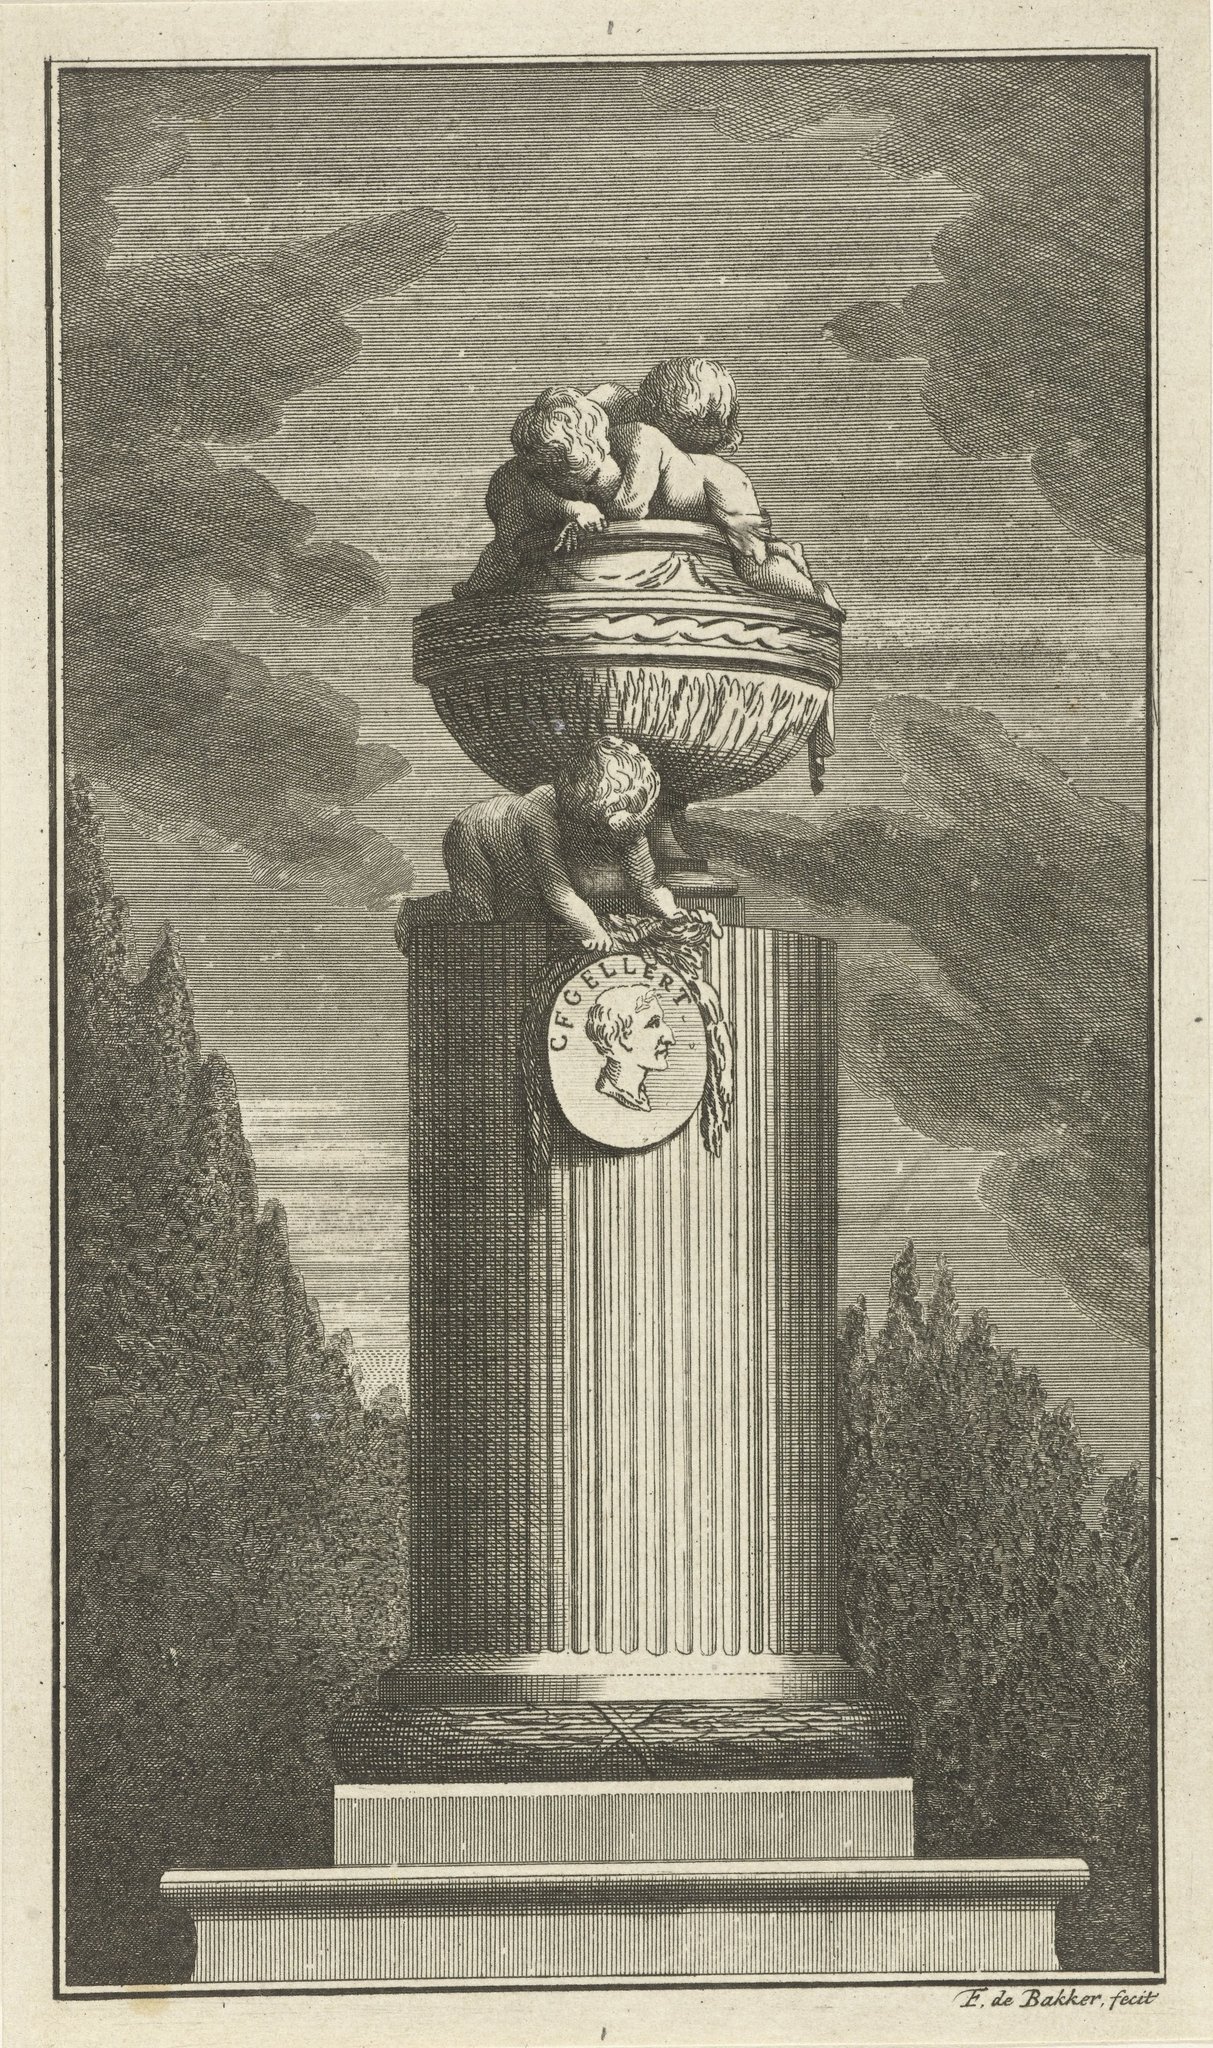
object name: print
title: Monument voor Christian Furchtegott Gellert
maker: frans de bakker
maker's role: print maker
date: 1736-1767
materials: paper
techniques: engraving, etching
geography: amsterdam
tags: grave, tomb and other grave-forms and grave-markers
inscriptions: collector's mark: Lugt 2228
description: Stenen zuil met urn. Op de urn slapen twee putti, een derde decoreert een plaquette met een portretbuste van Gellert met bloemen.